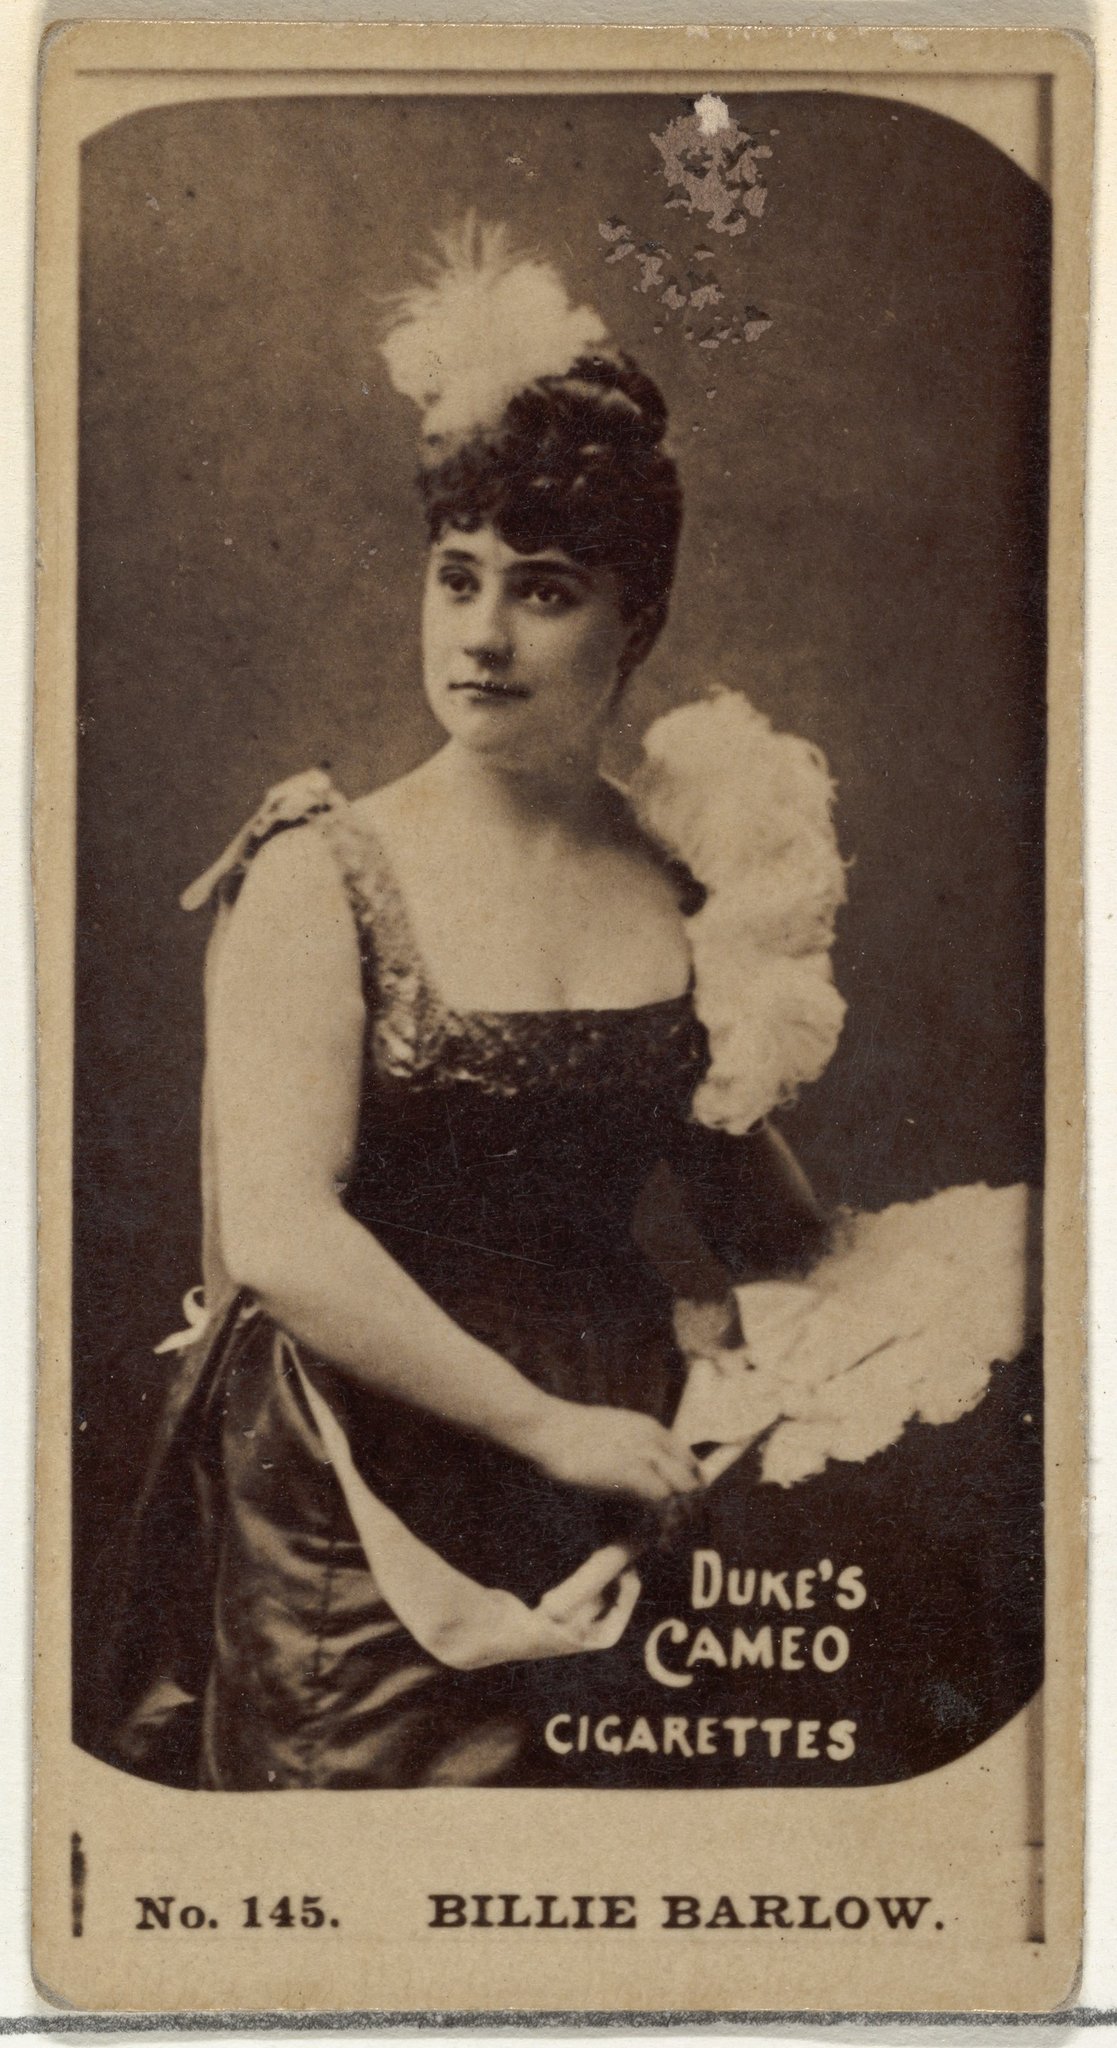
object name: photograph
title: Card Number 145, Billie Barlow, from the Actors and Actresses series (N145-4) issued by Duke Sons & Co. to promote Cameo Cigarettes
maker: w. duke, sons & co.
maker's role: publisher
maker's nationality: american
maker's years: 1870-1920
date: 1880-1889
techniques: albumen silver print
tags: portraits,women,actresses